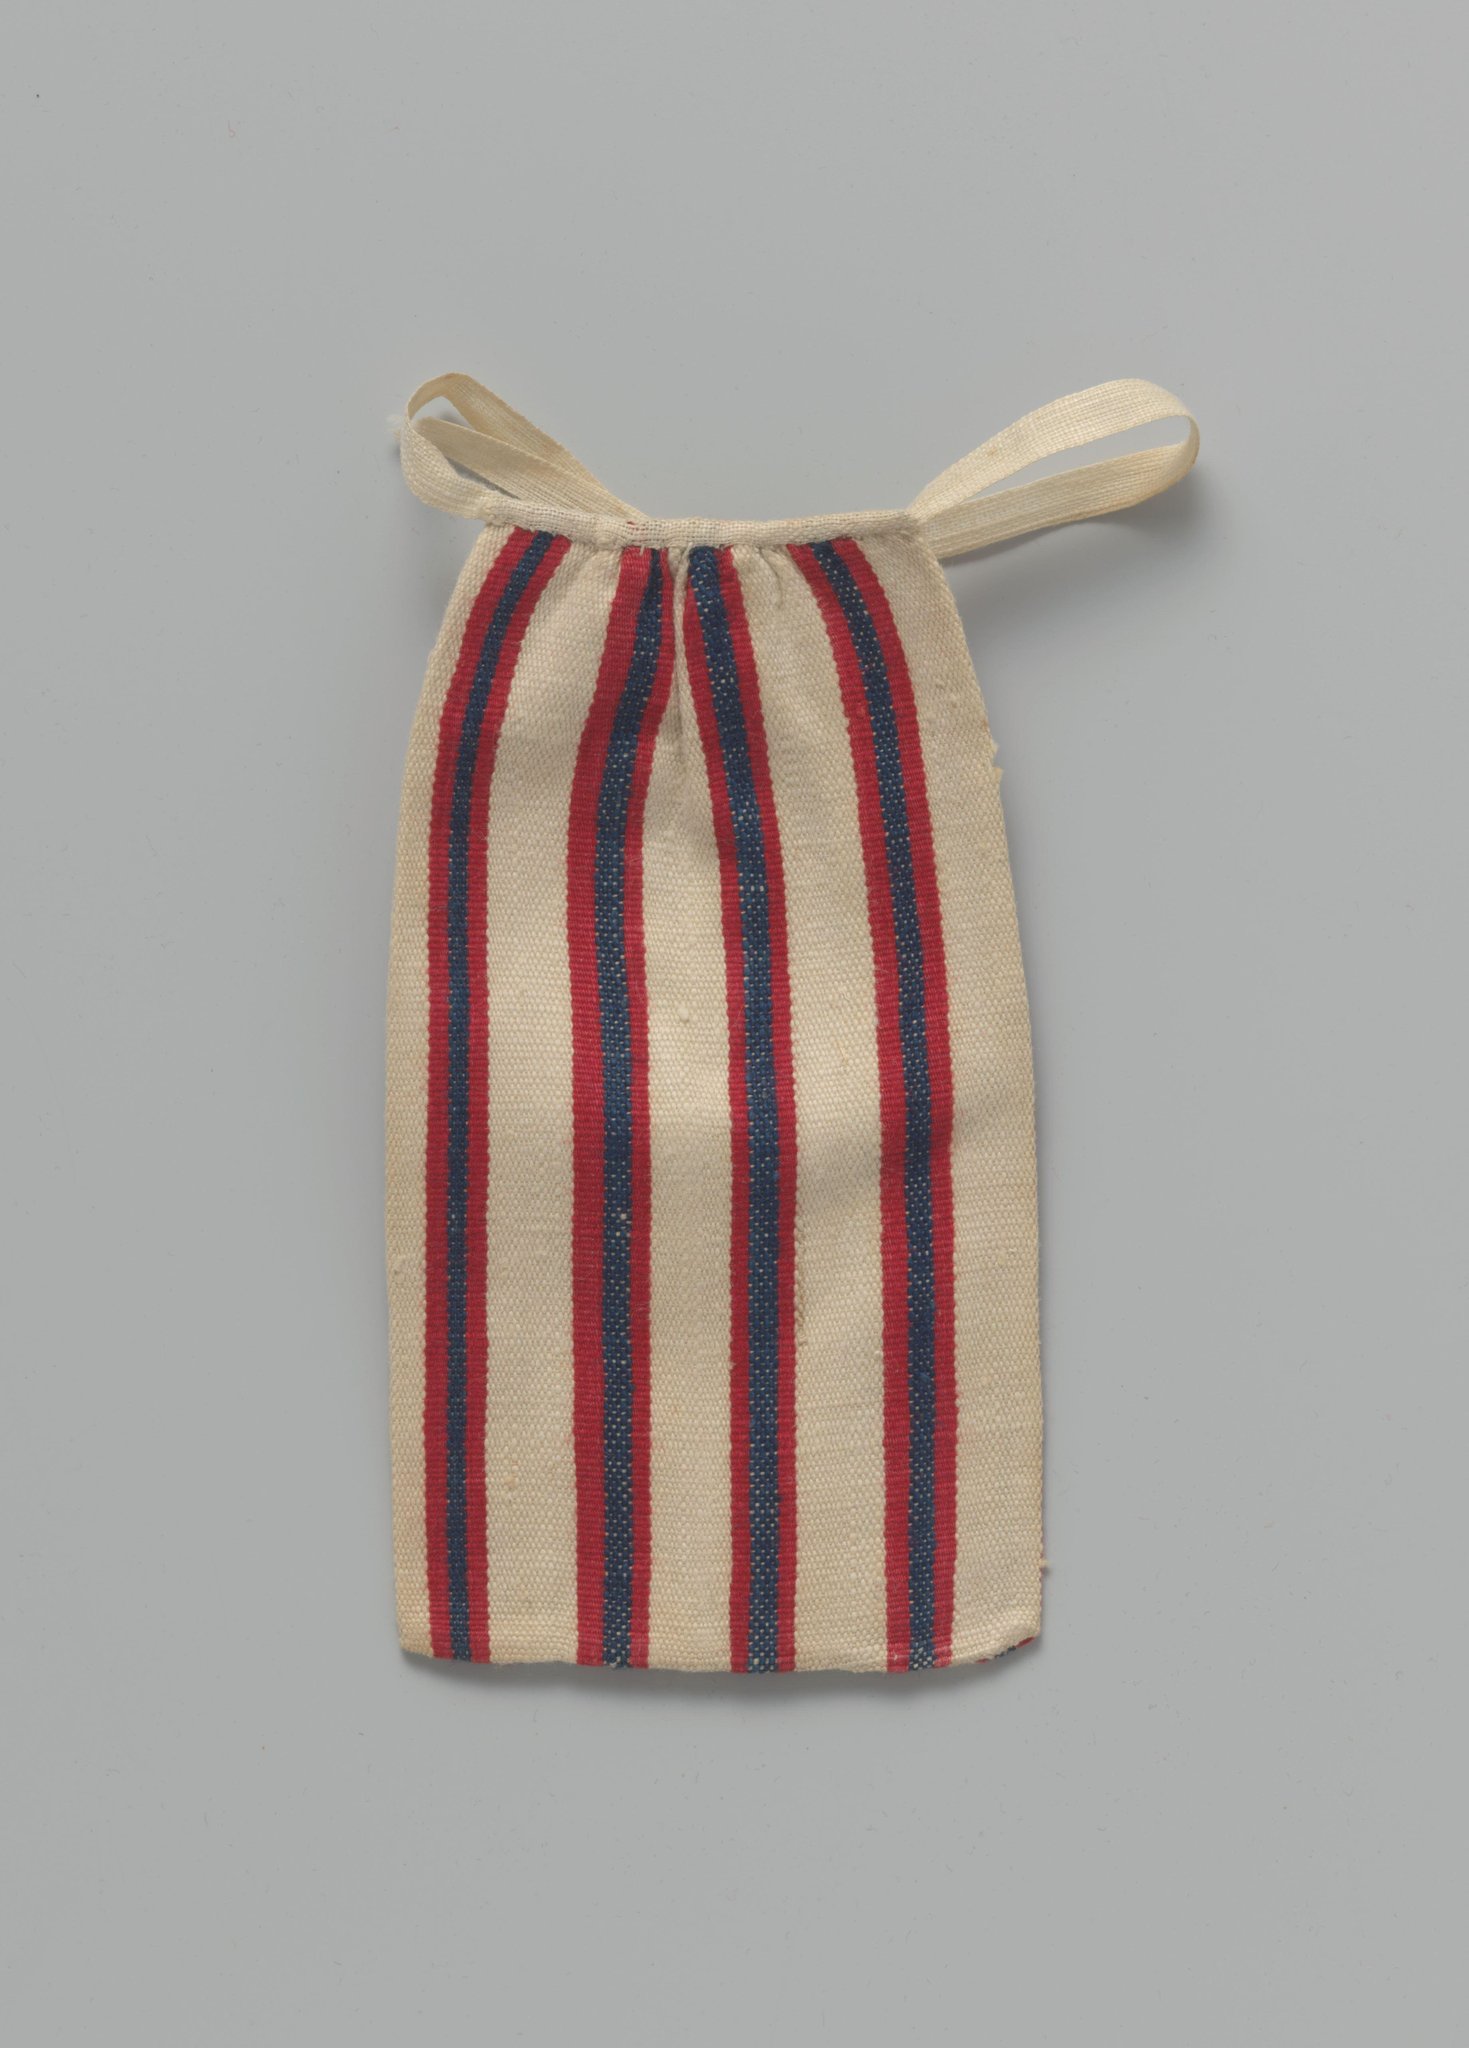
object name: clothing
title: Zak van rood en wit en zwart gestreepte keperkatoen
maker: Anonymous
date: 1850-1900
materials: cotton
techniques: weave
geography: netherlands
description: Zak van rood en wit en zwart gestreepte keperkatoen.